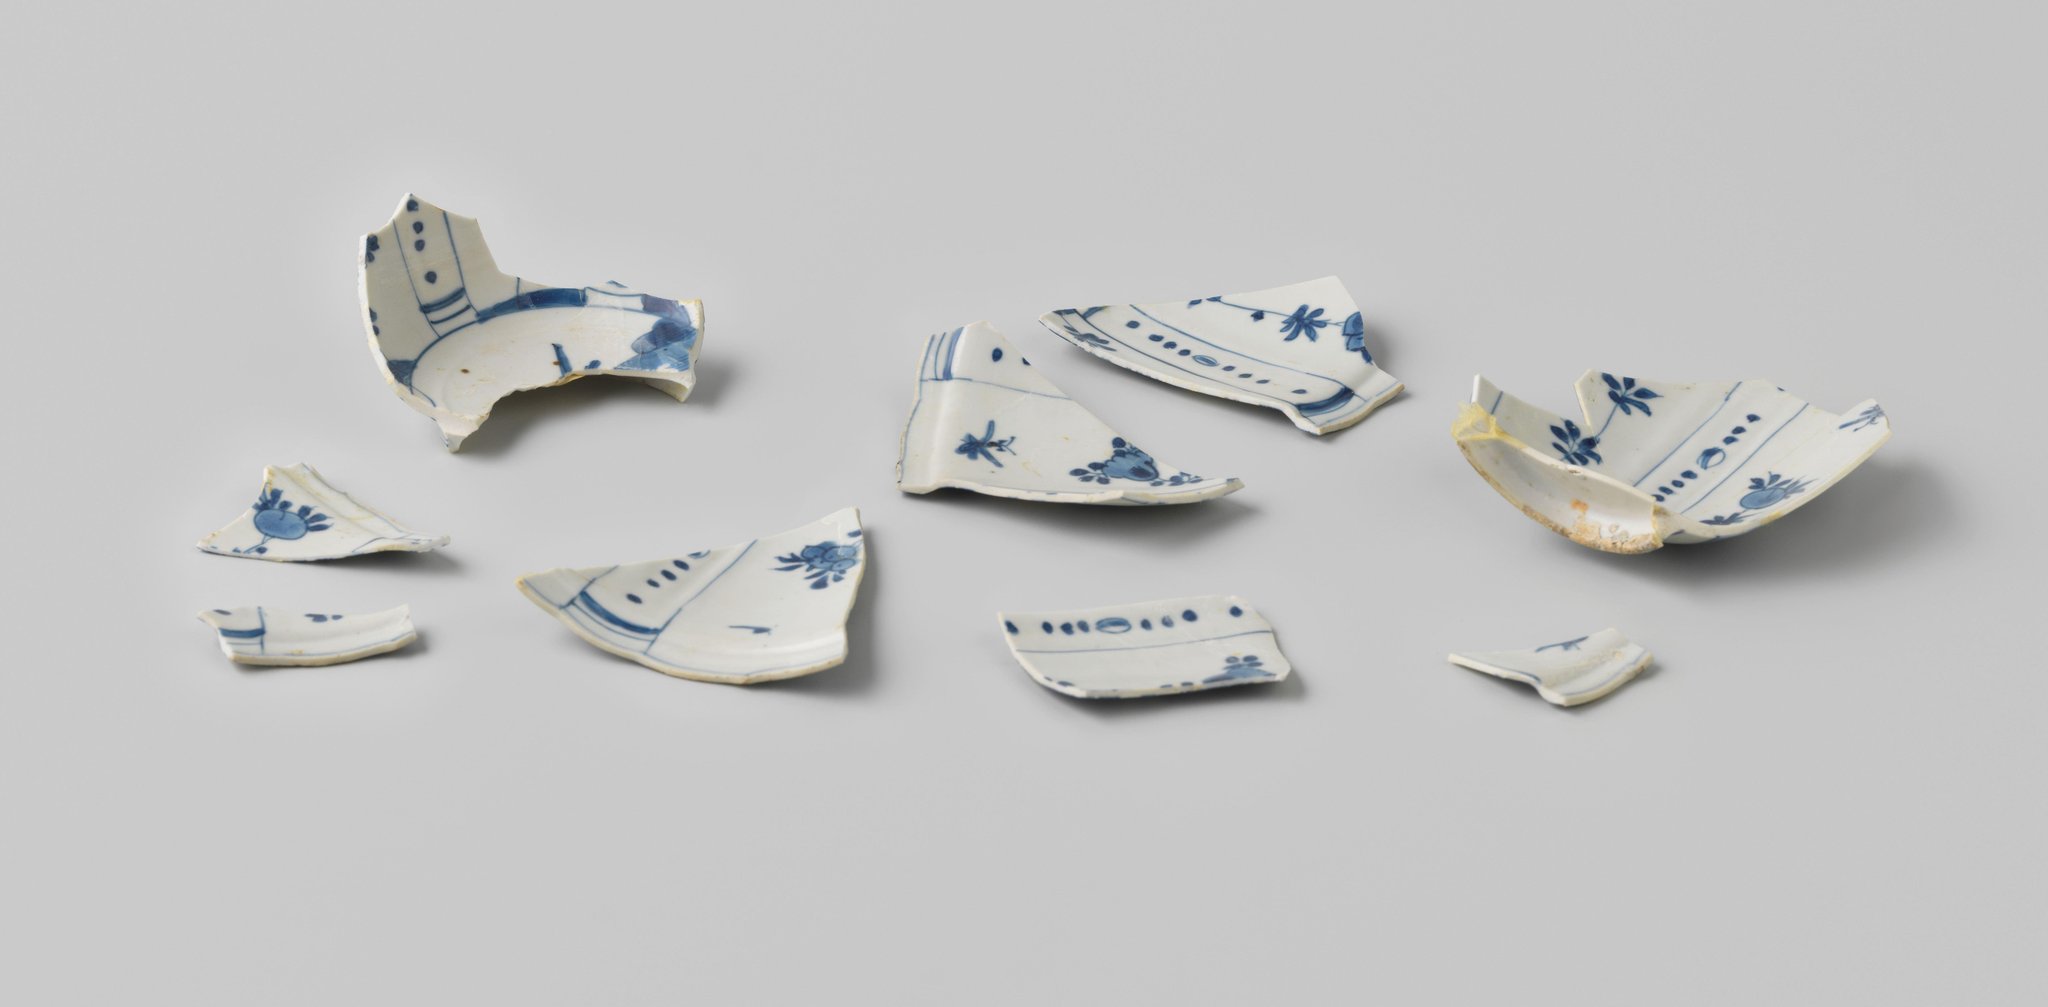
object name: bowl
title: Scherven van een kraaikop uit V.O.C.-schip de 'Witte Leeuw'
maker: Anonymous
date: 1613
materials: bone china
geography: jingdezhen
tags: verenigde oostindische compagnie, sint-helena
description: A high bowl. The inside decorated with flower- and fruit-sprays. The exterior with flowers and butterflies.